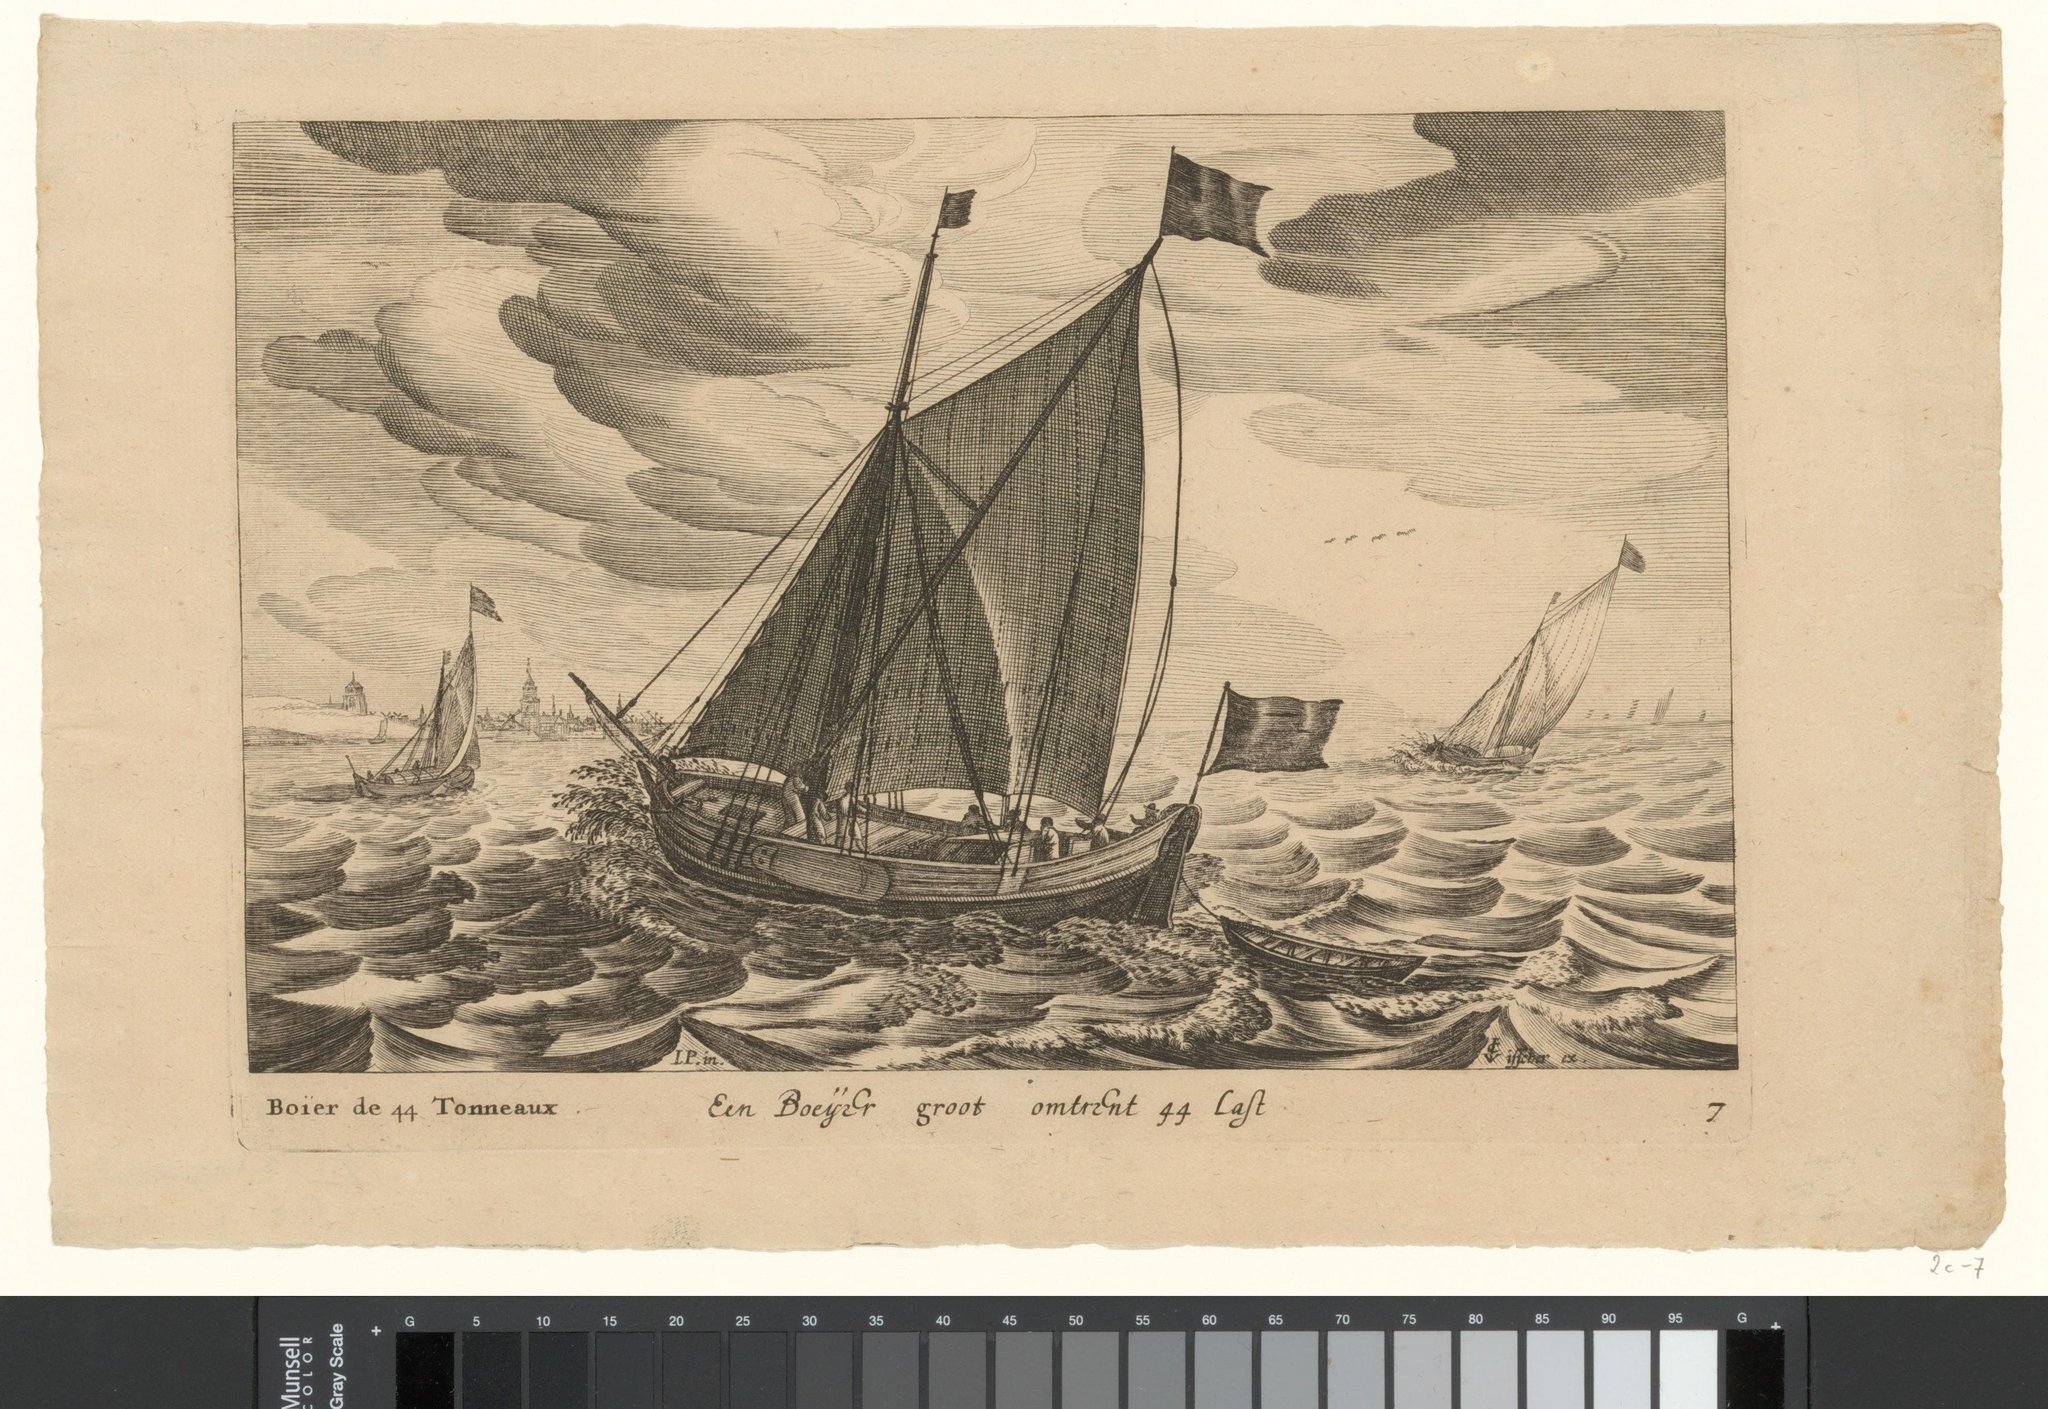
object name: print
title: Diverse navires dont on se sert dans les Provinces Unies / Icones variarum navium Hollandicarum quarum usus maximè in aquis interioribus regionis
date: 1717-1779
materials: paper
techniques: engraving, etching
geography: haarlem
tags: sailing-ship, sailing-boat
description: Boeiers op het water. Rechtsonder genummerd: 7. Onderwerpsrubrieken binnen de Atlas Zeden en Gewoonten: Handel, Nijverheid en Verkeer, Scheepsvaart.